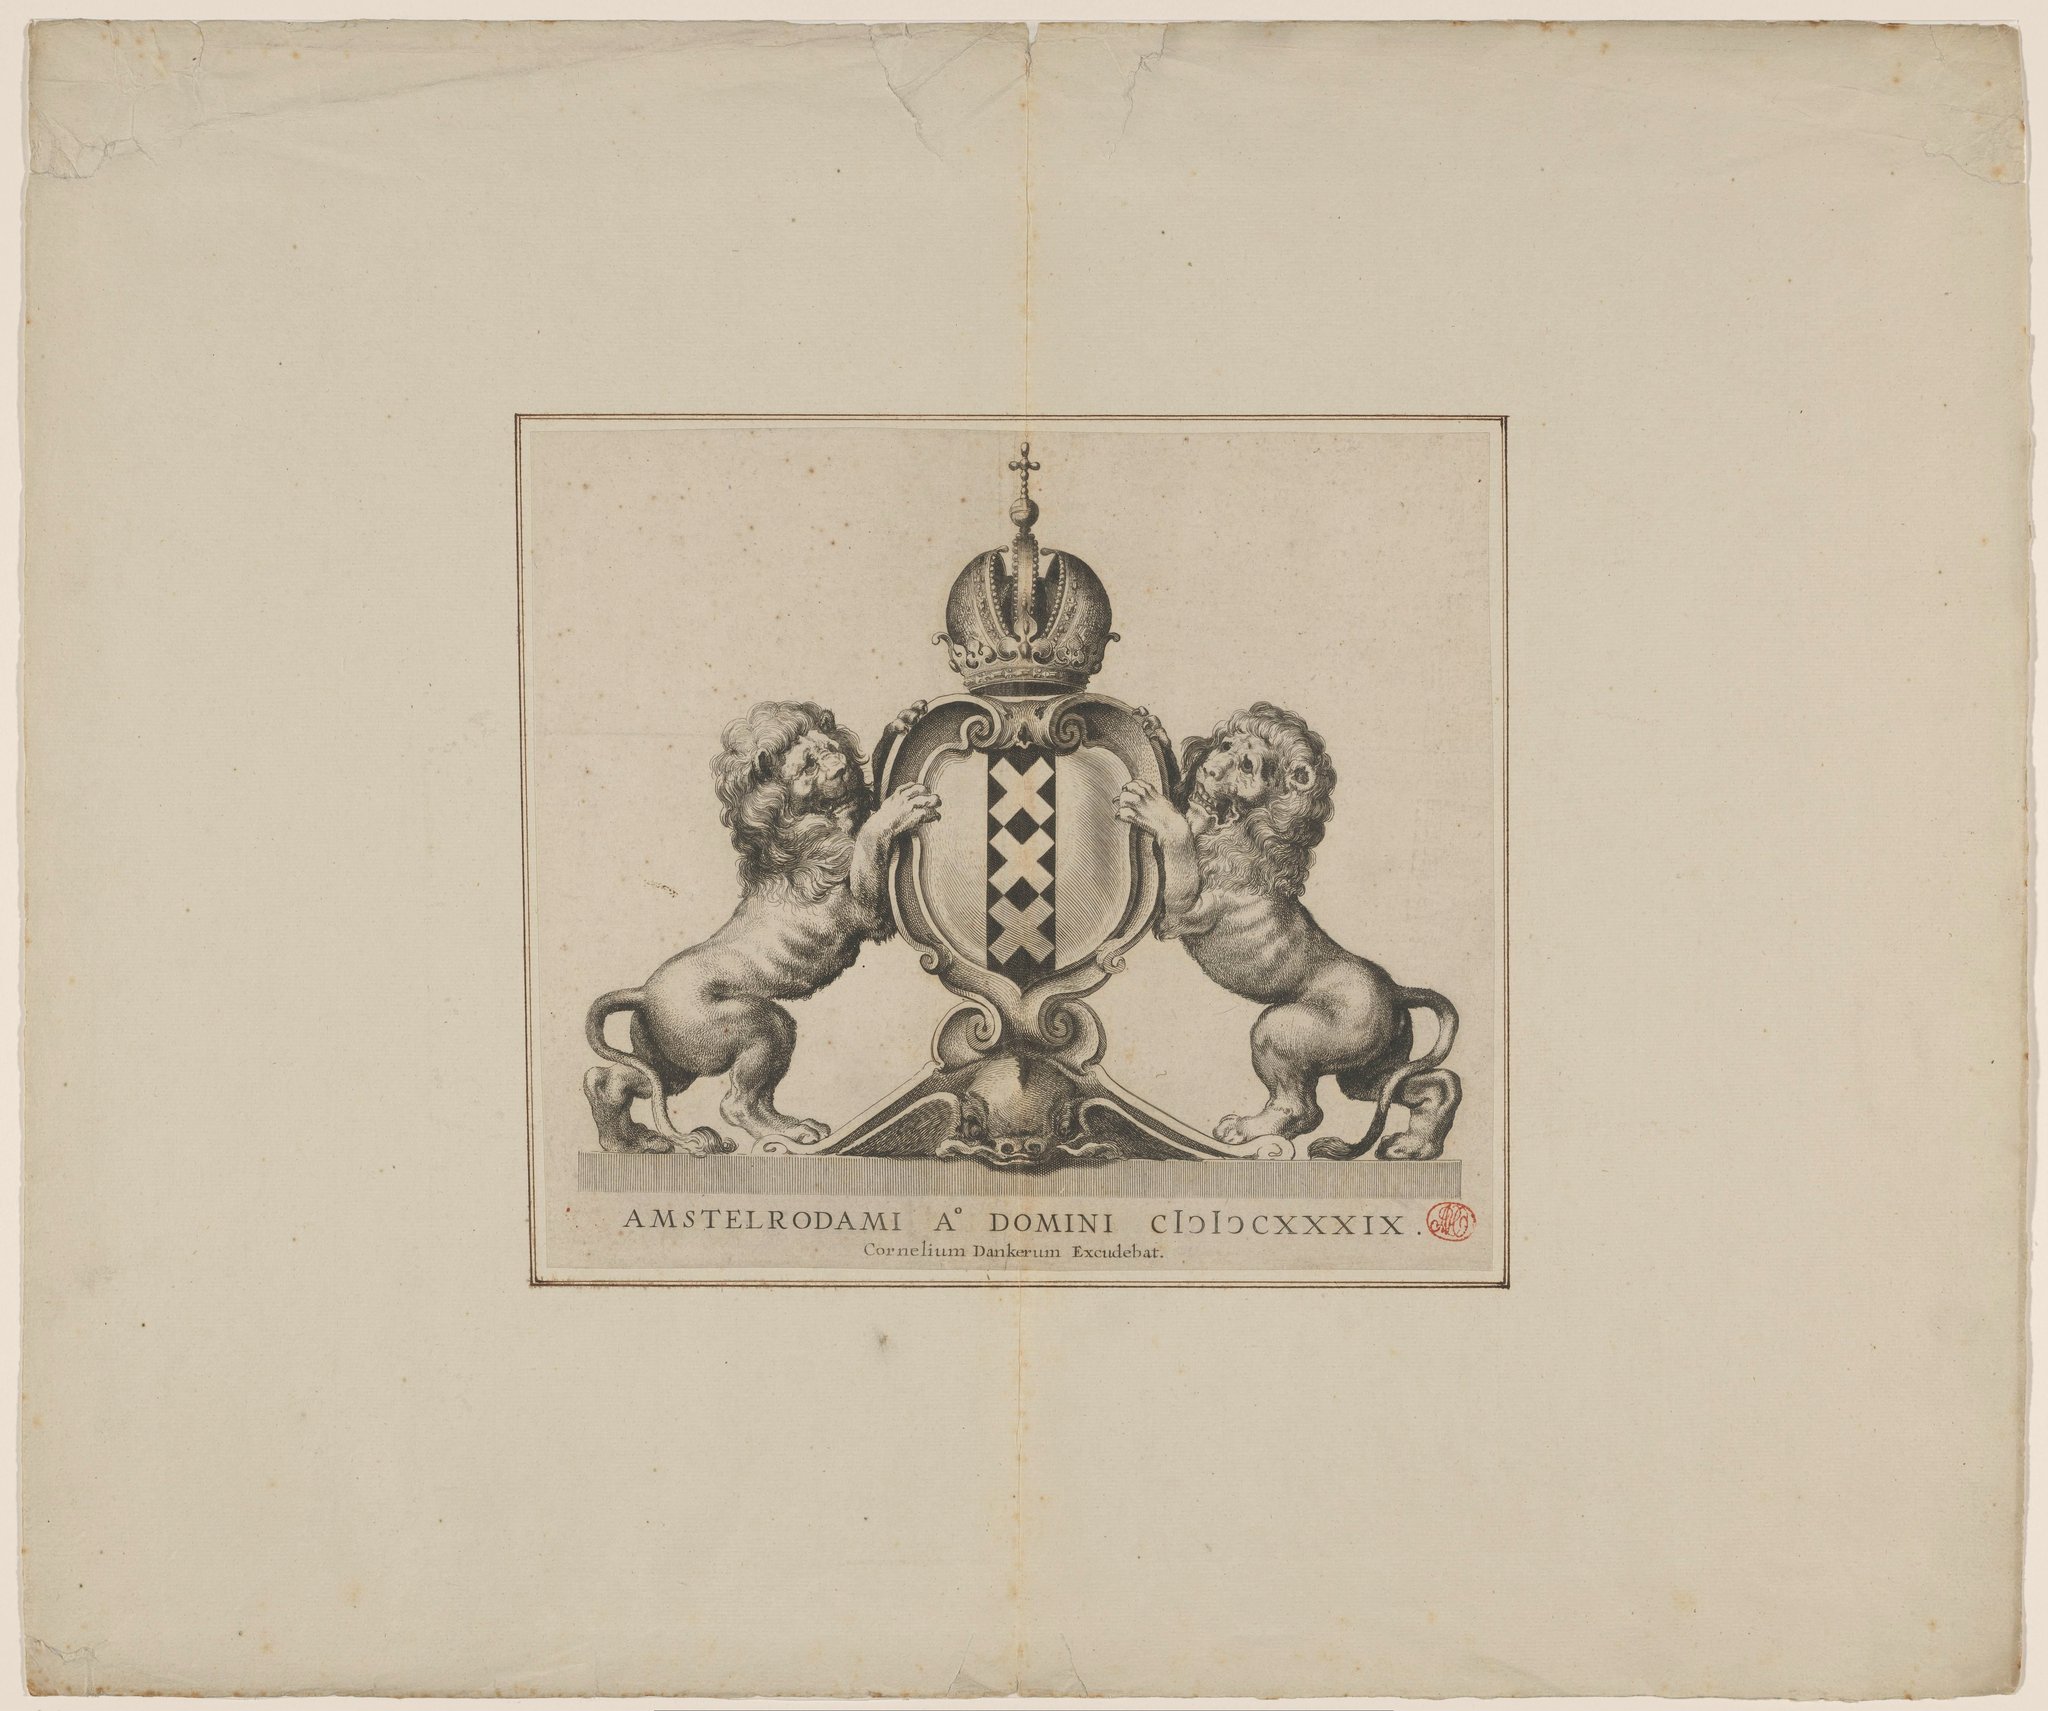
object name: print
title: Amstelrodami Ao domini CIƆIƆCXXXIX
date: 1639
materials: paper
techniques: engraving, etching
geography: amsterdam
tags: coat of arms (as symbol of the state, etc.) (+ city; municipal), dolphin ~ ornament, beasts of prey, predatory animals: lion, amsterdam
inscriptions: collector's mark: Lugt 195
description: Prent waarschijnlijk ook gebruikt in : Baerle, Caspar van en Joost van den Vondel. Blyde Inkomst der allerdoorluchtighste Koninginne, Maria de Medicis, t' Amsterdam, vertaeld uit het Latijn (…). Amsterdam: Cornelis Danckertsz. I, 1639.* *Niet te verwarren met de gelijknamige uitgave uitgegeven door Johannes en Cornelis Willemsz. Blaeu.